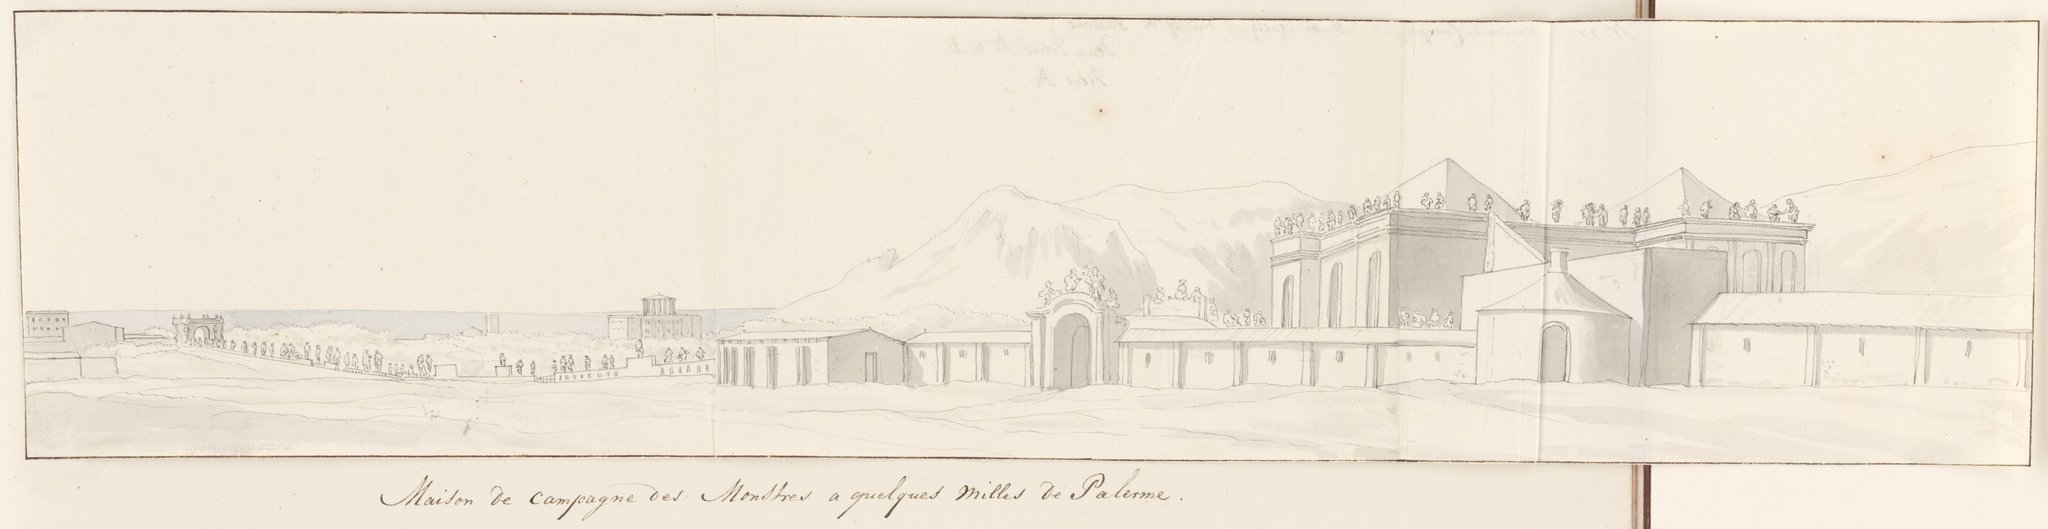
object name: watercolor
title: Maison de campagne des Monstres à quelques milles de Palerme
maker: louis ducros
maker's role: draughtsman, print maker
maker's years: 1748-1810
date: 1778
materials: chalk, paper, watercolor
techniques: brush, pen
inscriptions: inscription: ‘No 274 Maison de campagne des Monstres à quelques milles de Palerme’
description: Tekening uit het album 'Voyage en Italie, en Sicile et à Malte', 1778.